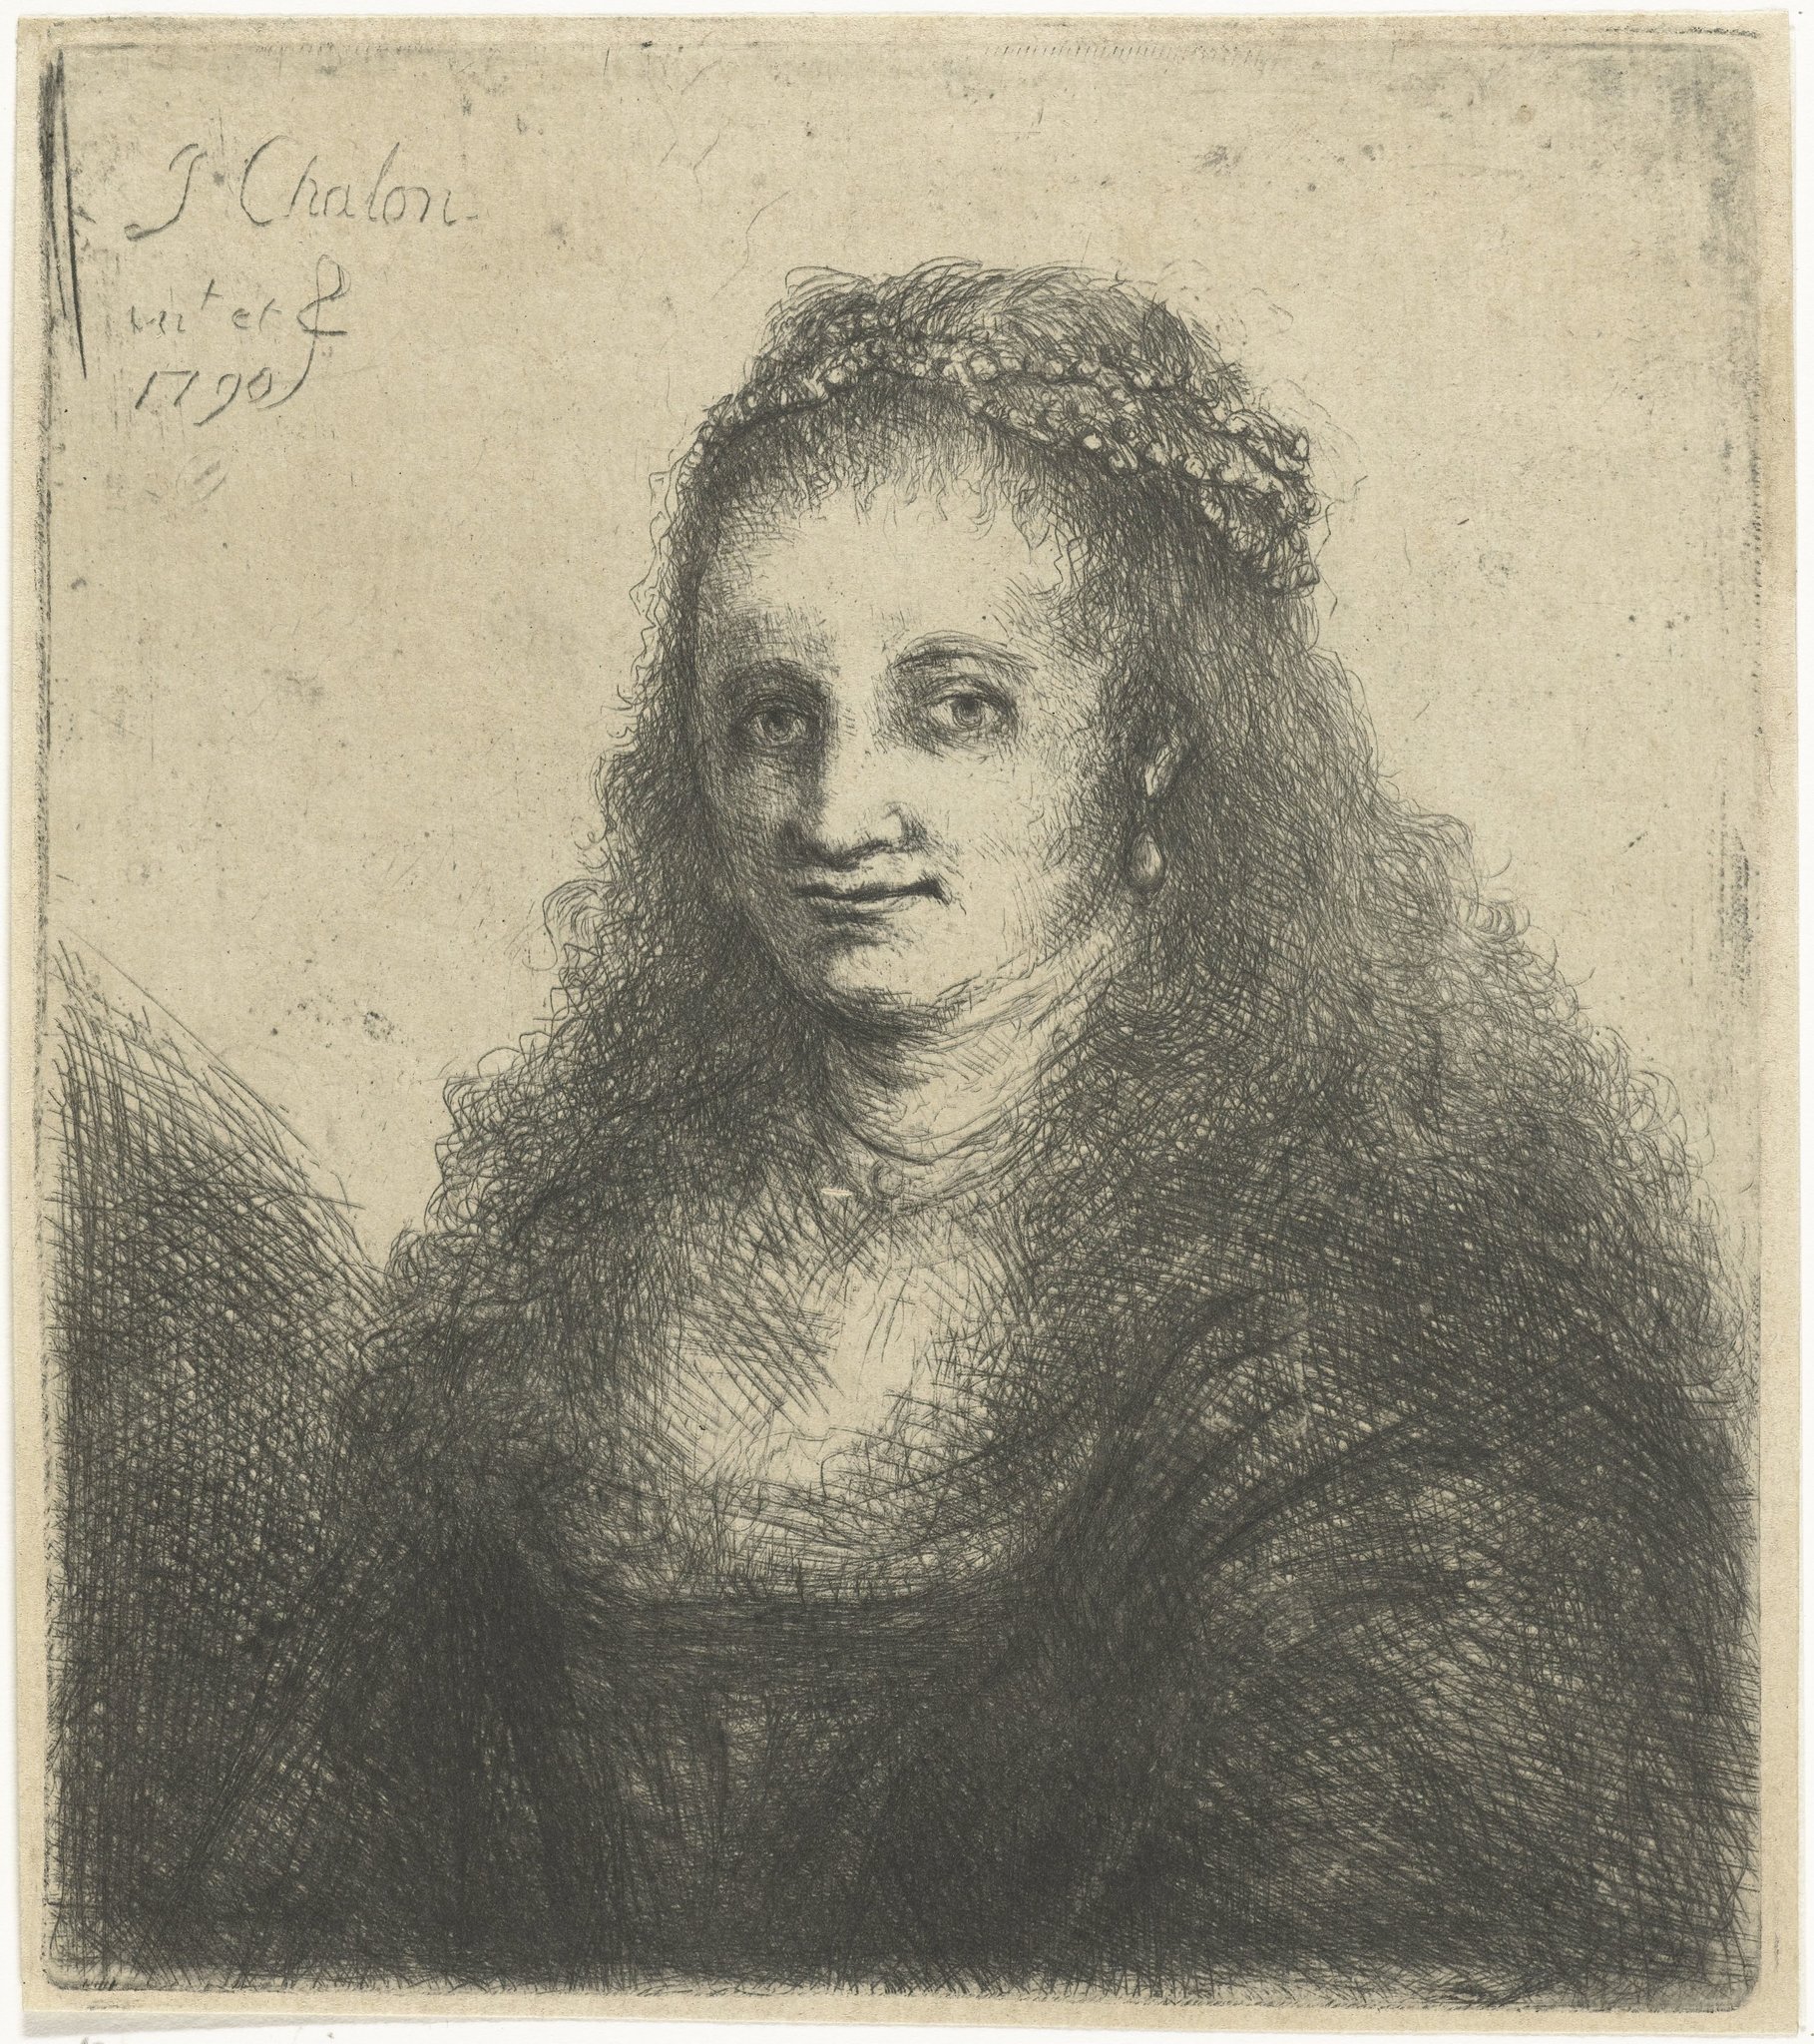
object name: print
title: Vrouw met een parelsnoer in het haar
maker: jan chalon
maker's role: print maker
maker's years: 1738-1795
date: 1790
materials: paper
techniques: drypoint, etching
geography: northern netherlands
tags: head-gear, pearl; pearl necklace, morphology of human expression (+ adult female (human being))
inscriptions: collector's mark: Lugt 2228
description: Een jonge vrouw. Buste naar links. Ze draagt een parelsnoer in haar haar.